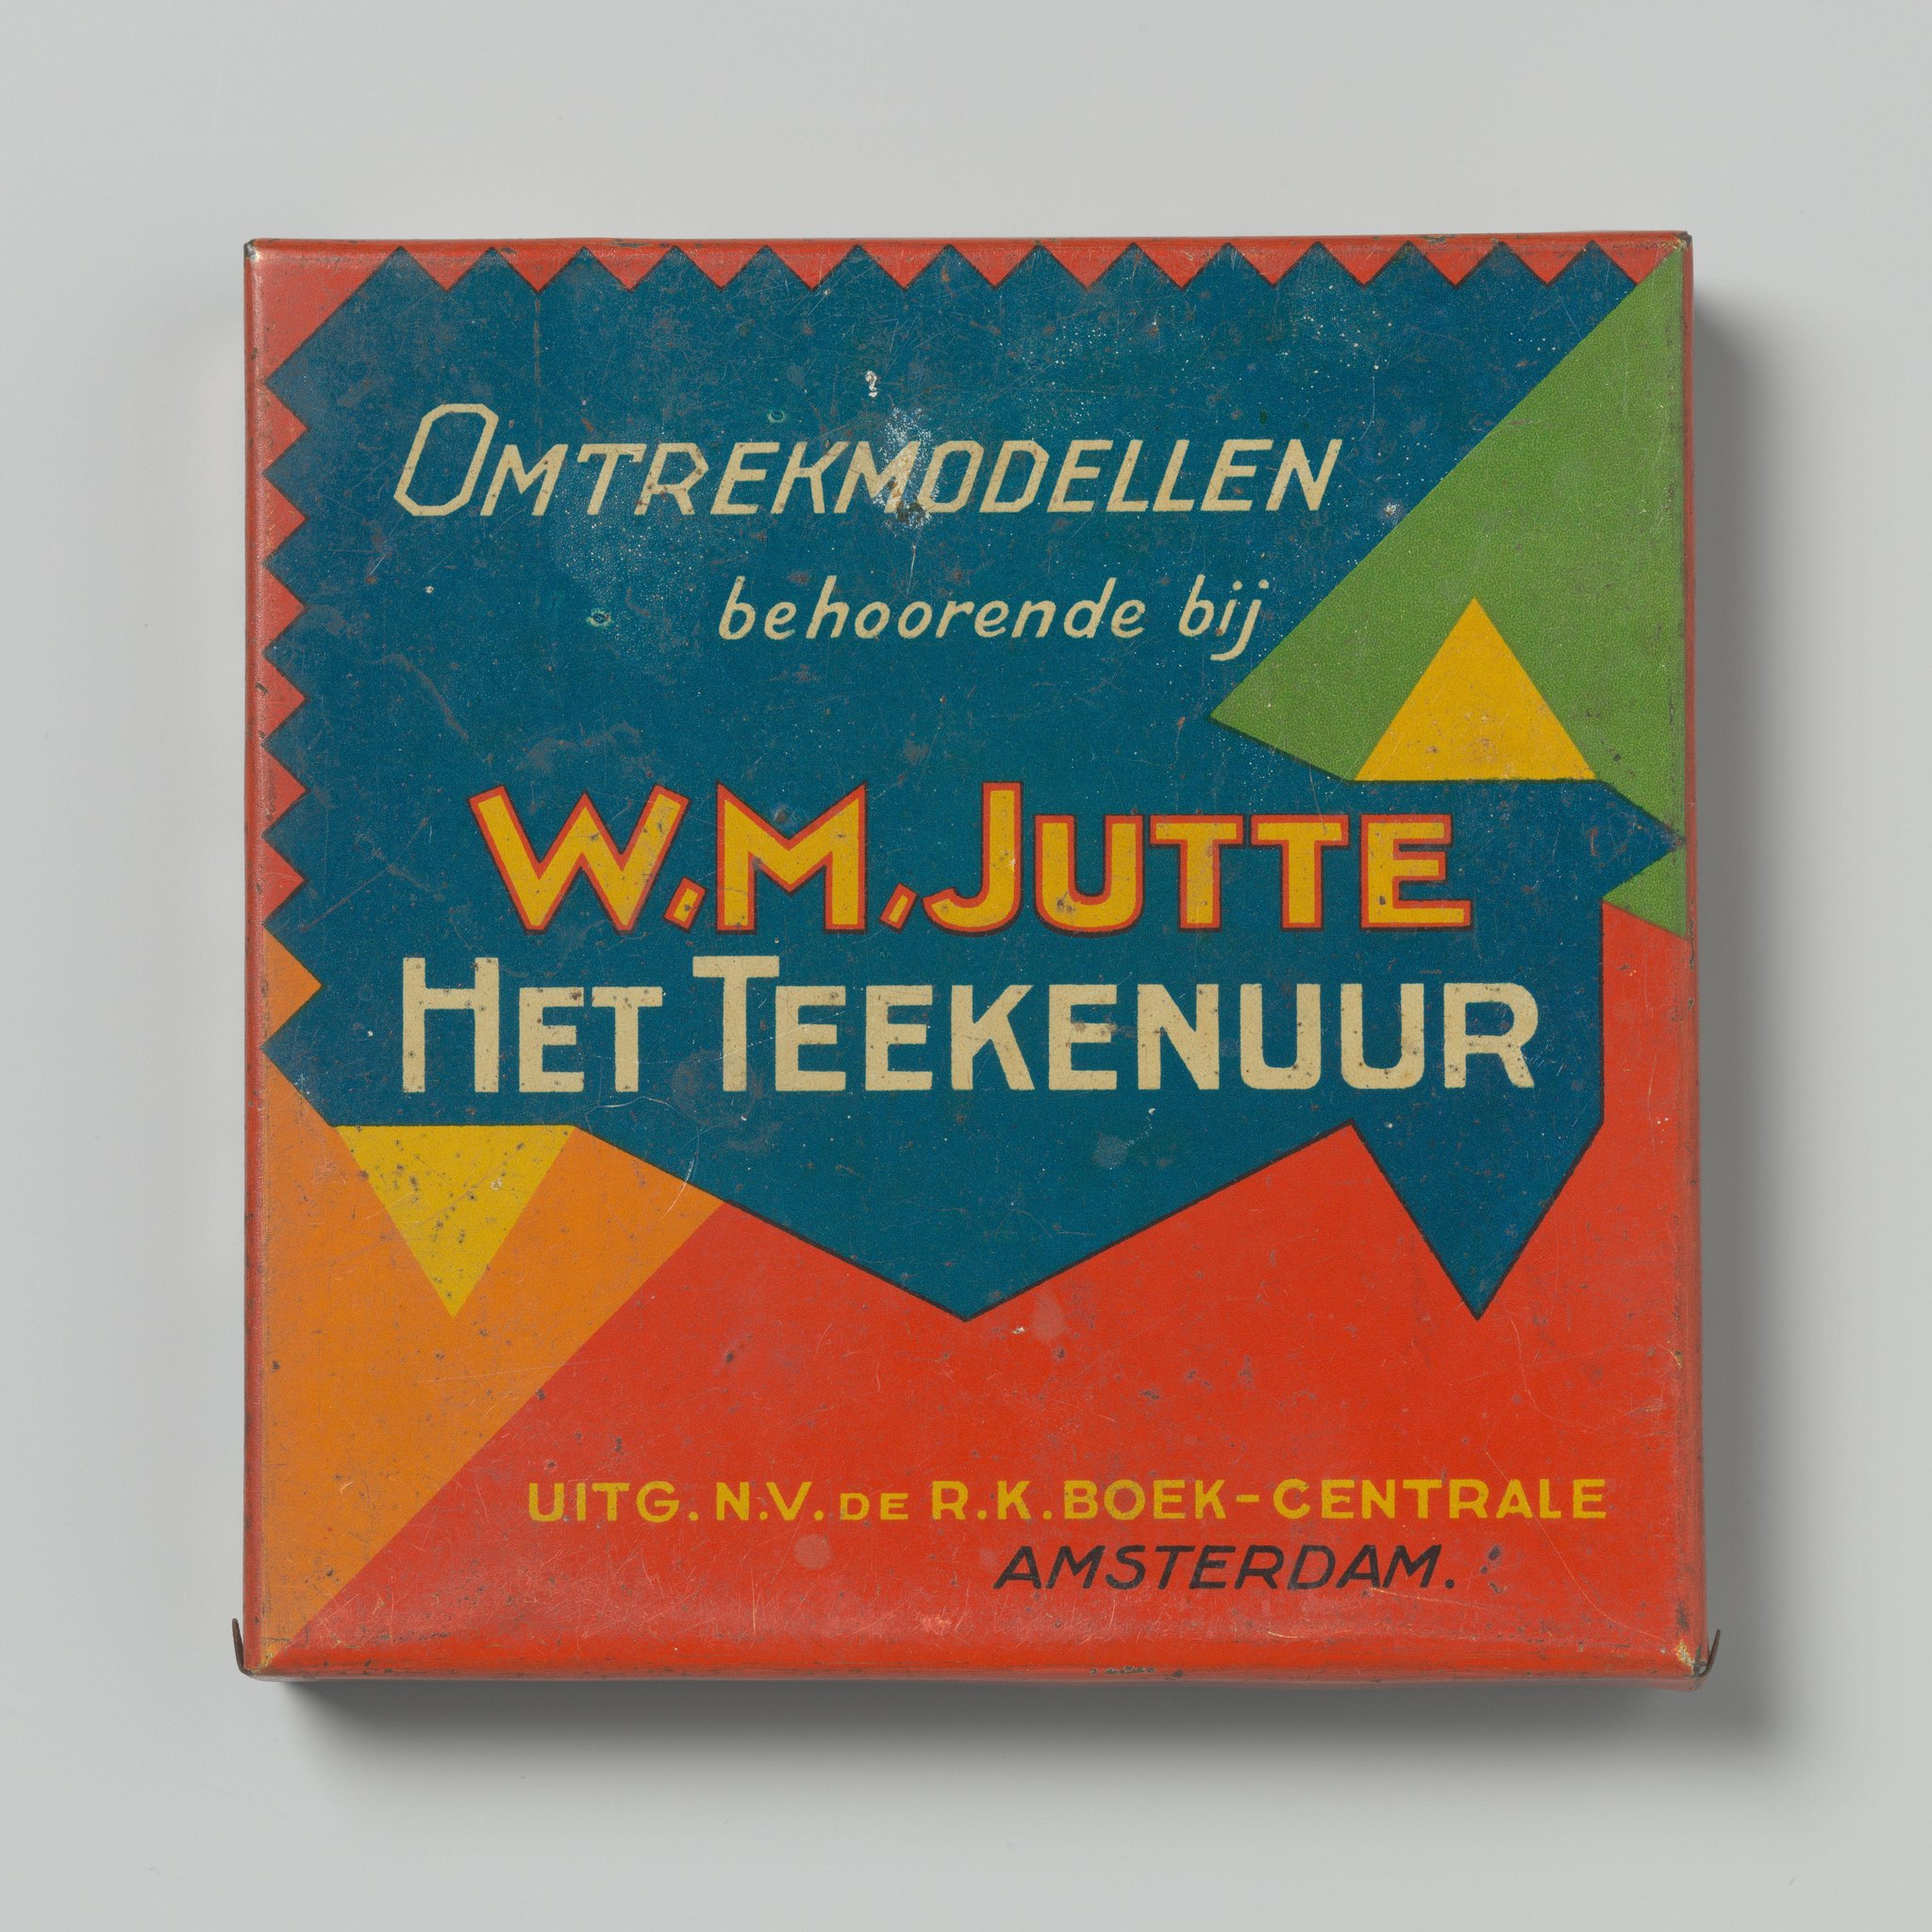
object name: can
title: Blik met opdruk “OMTREKMODELLEN / behoorende bij / W.M. JUTTE / HET TEEKENUUR / UITG. N.V. DE R.K. BOEK-CENTRALE / AMSTERDAM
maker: jac jongert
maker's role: print maker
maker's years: 1883-1942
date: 1920-1940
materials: metal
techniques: printing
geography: netherlands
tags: amsterdam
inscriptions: inscription: ‘OMTREKMODELLEN / behoorende bij / W.M. JUTTE / HET TEEKENUUR / UITG. N.V. DE R.K. BOEK-CENTRALE / AMSTERDAM’